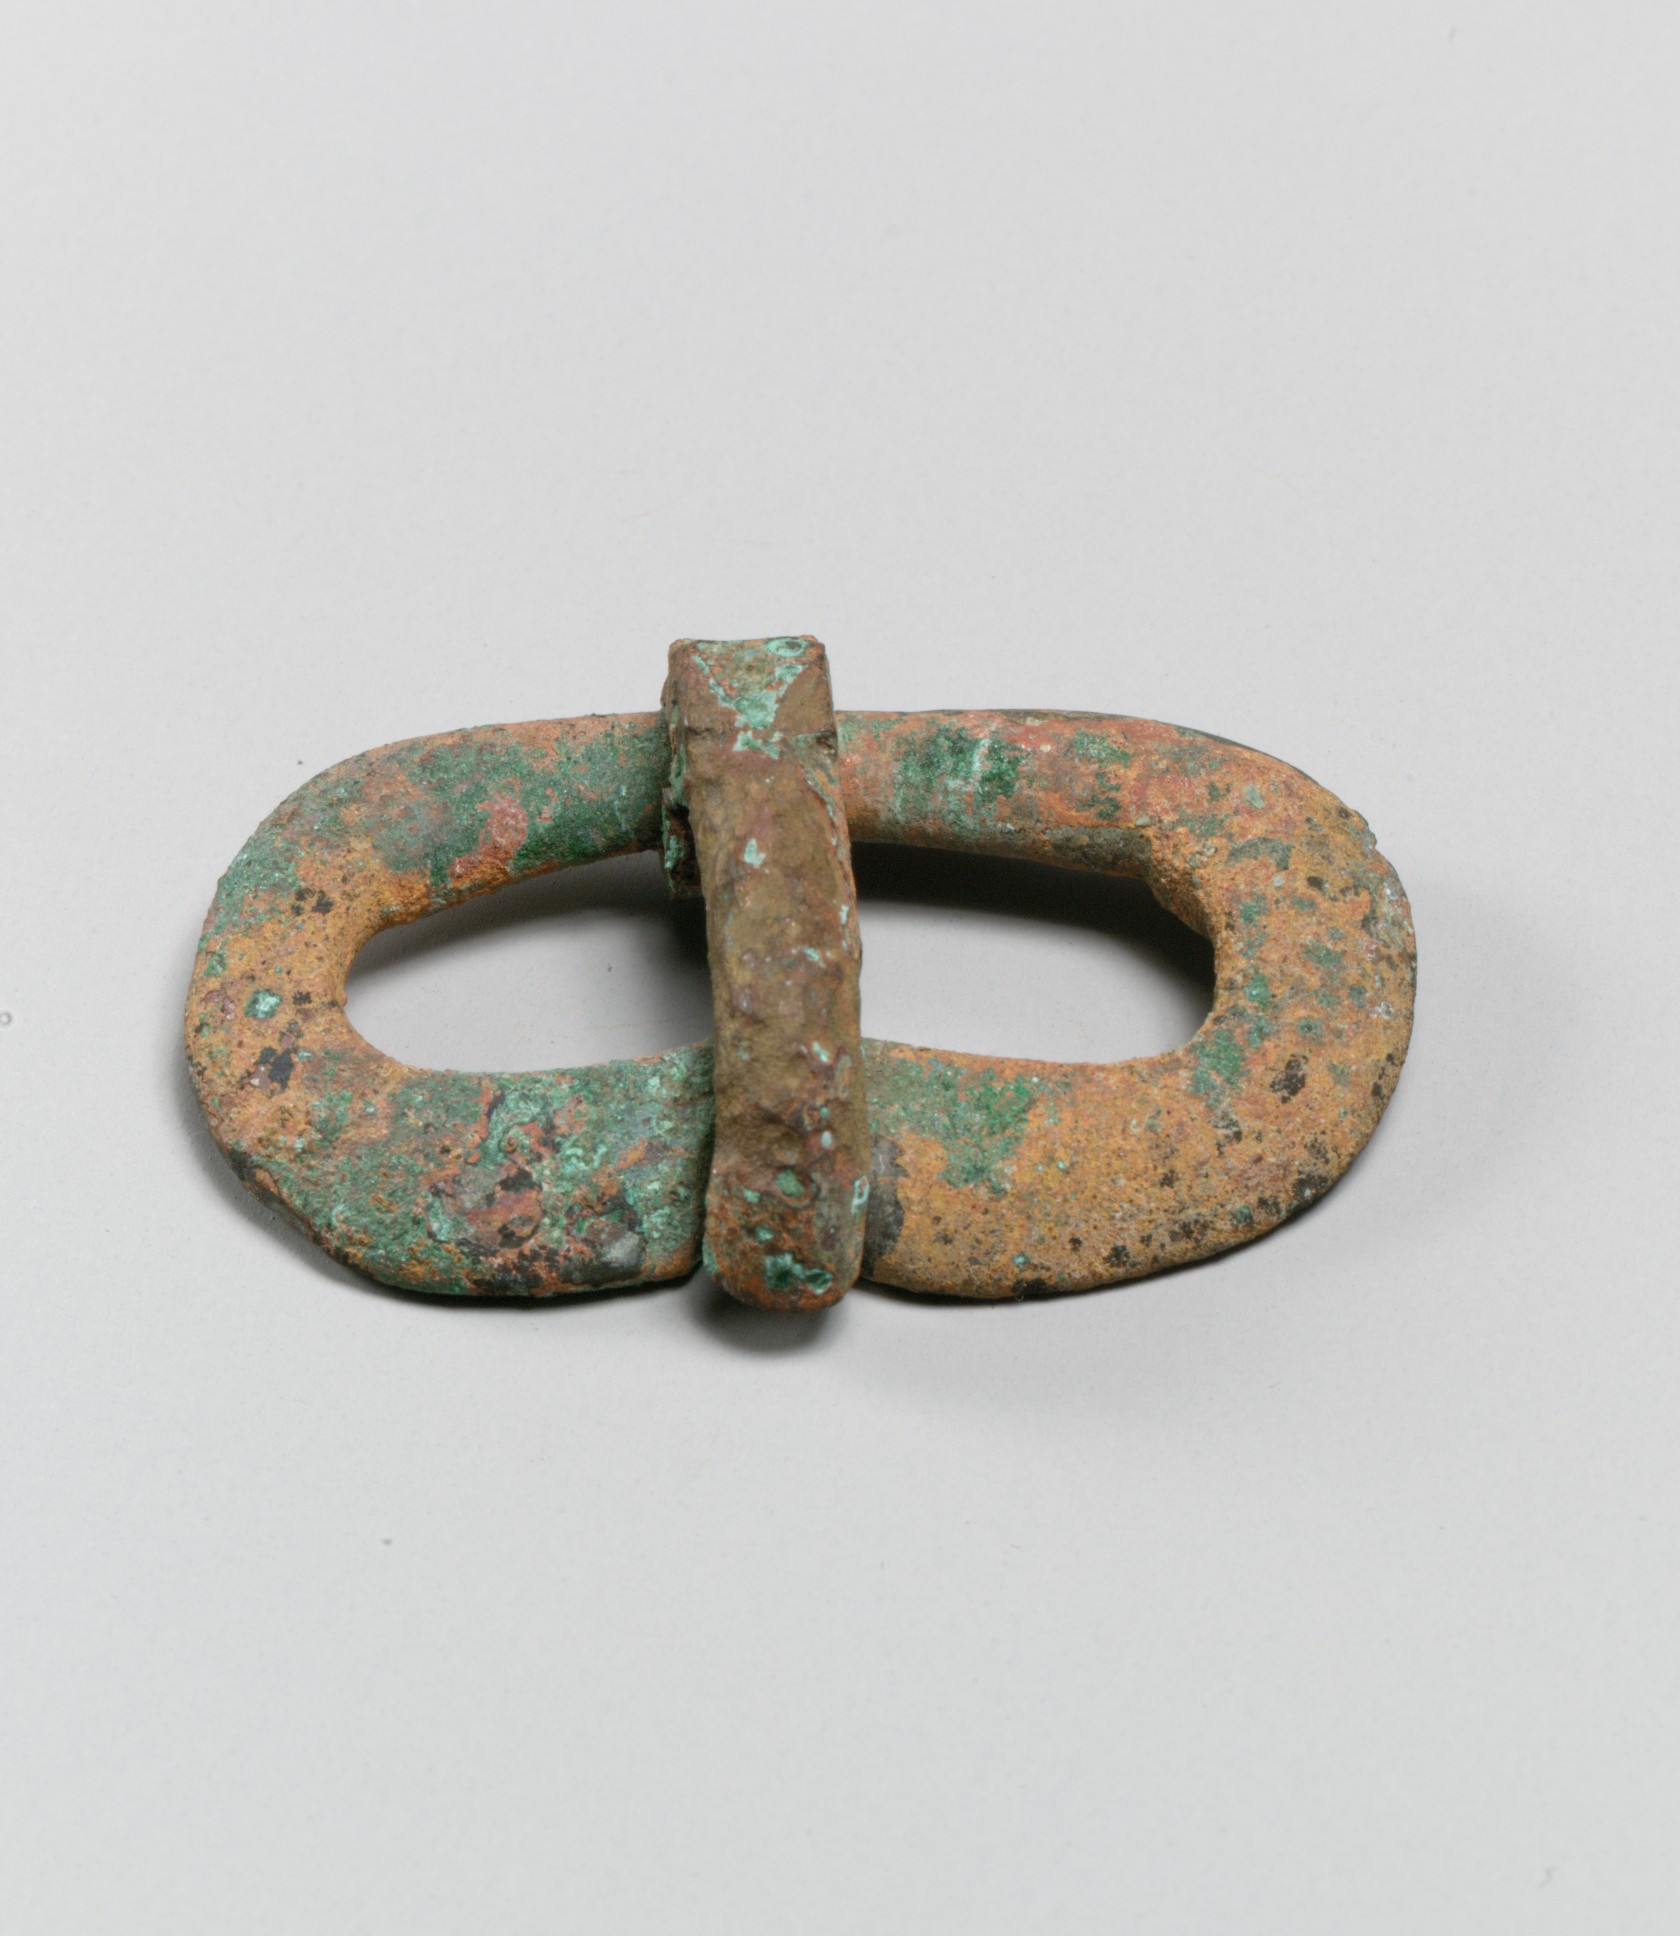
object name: buckle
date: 7000 BCE-330 CE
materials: bronze